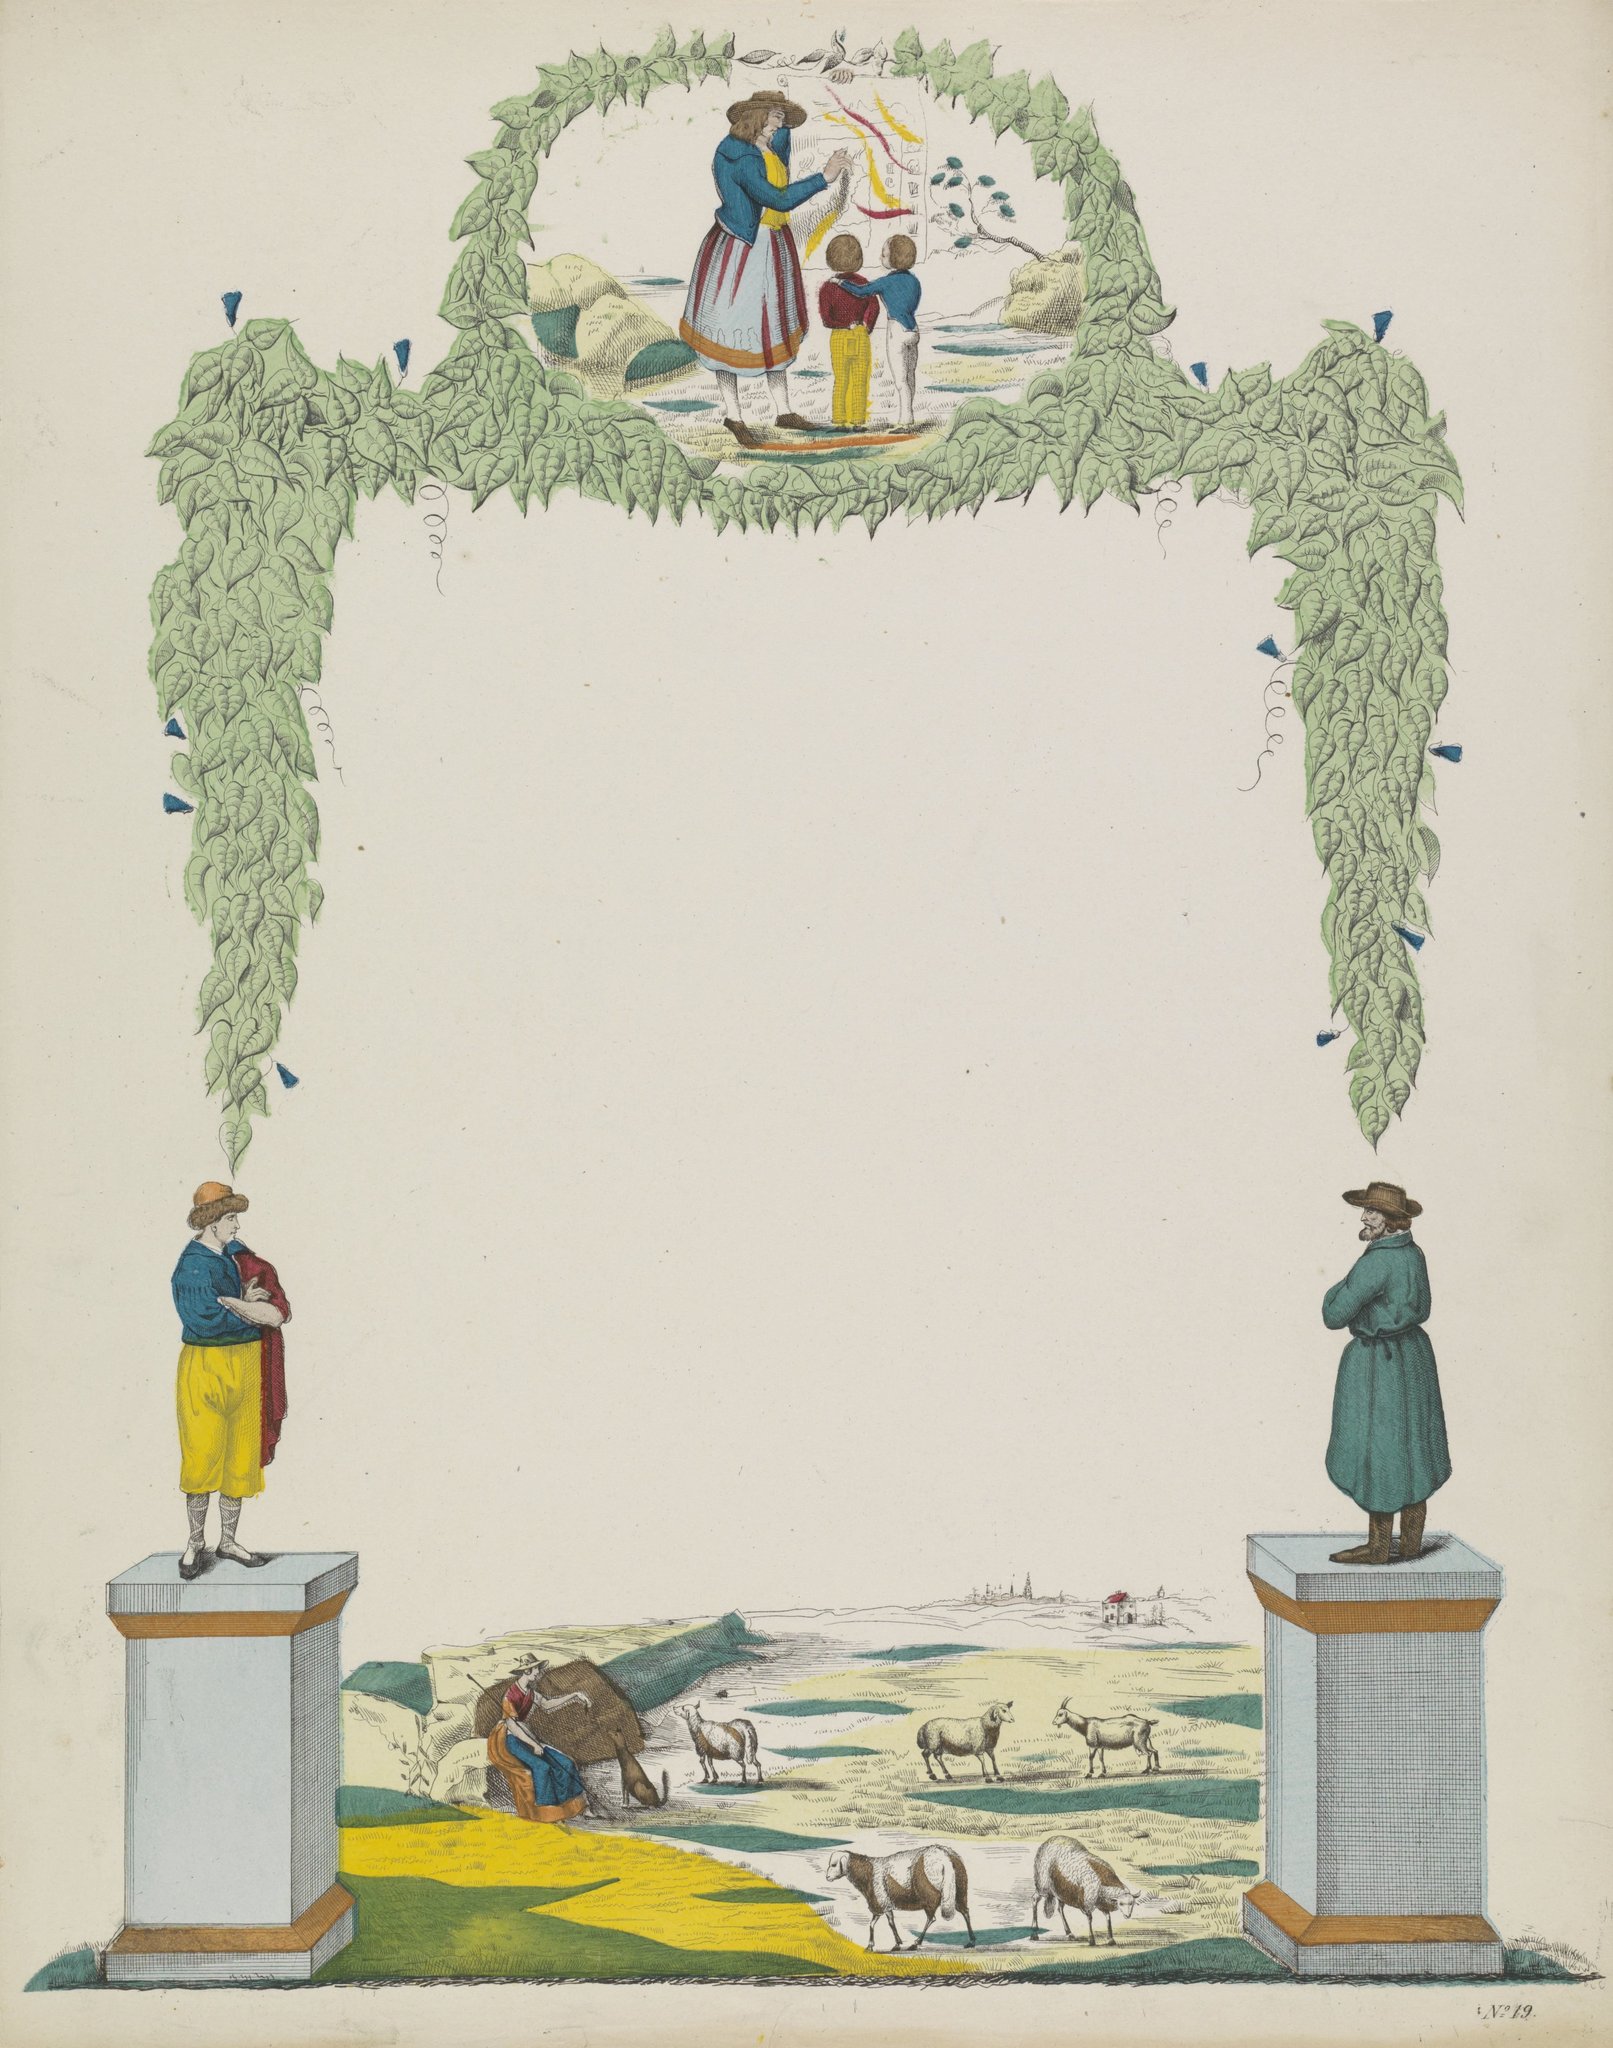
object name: wensbrief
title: Wensbrief met een herderin en haar schapen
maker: Anonymous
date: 1780-1899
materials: paper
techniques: colour, lithograph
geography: netherlands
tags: herding, herdsman, herdswoman, shepherd, shepherdess, cowherd, etc., maps, atlases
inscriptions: collector's mark: Lugt 2760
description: Wensbrief met onbeschreven cartouche binnen een decoratief kader met voorstellingen van een herderin en haar schapen, twee mannen op sokkels en een man die twee kinderen een landkaart laat zien. Genummerd rechtsonder: No. 19.